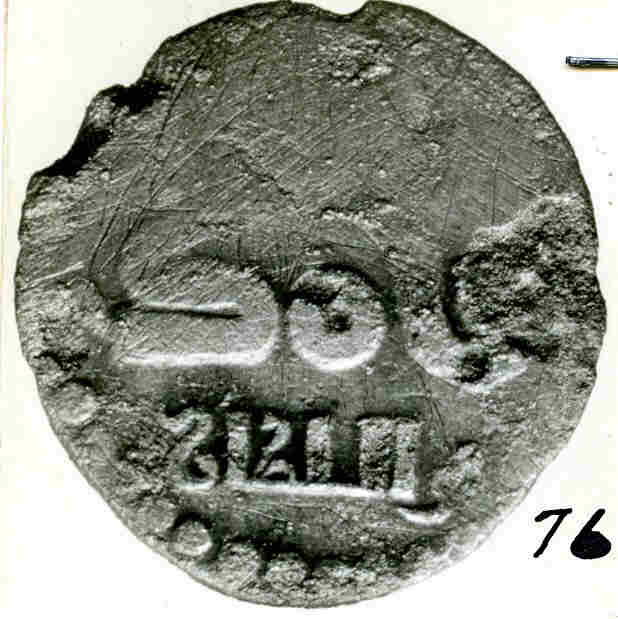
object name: coin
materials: copper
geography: iran